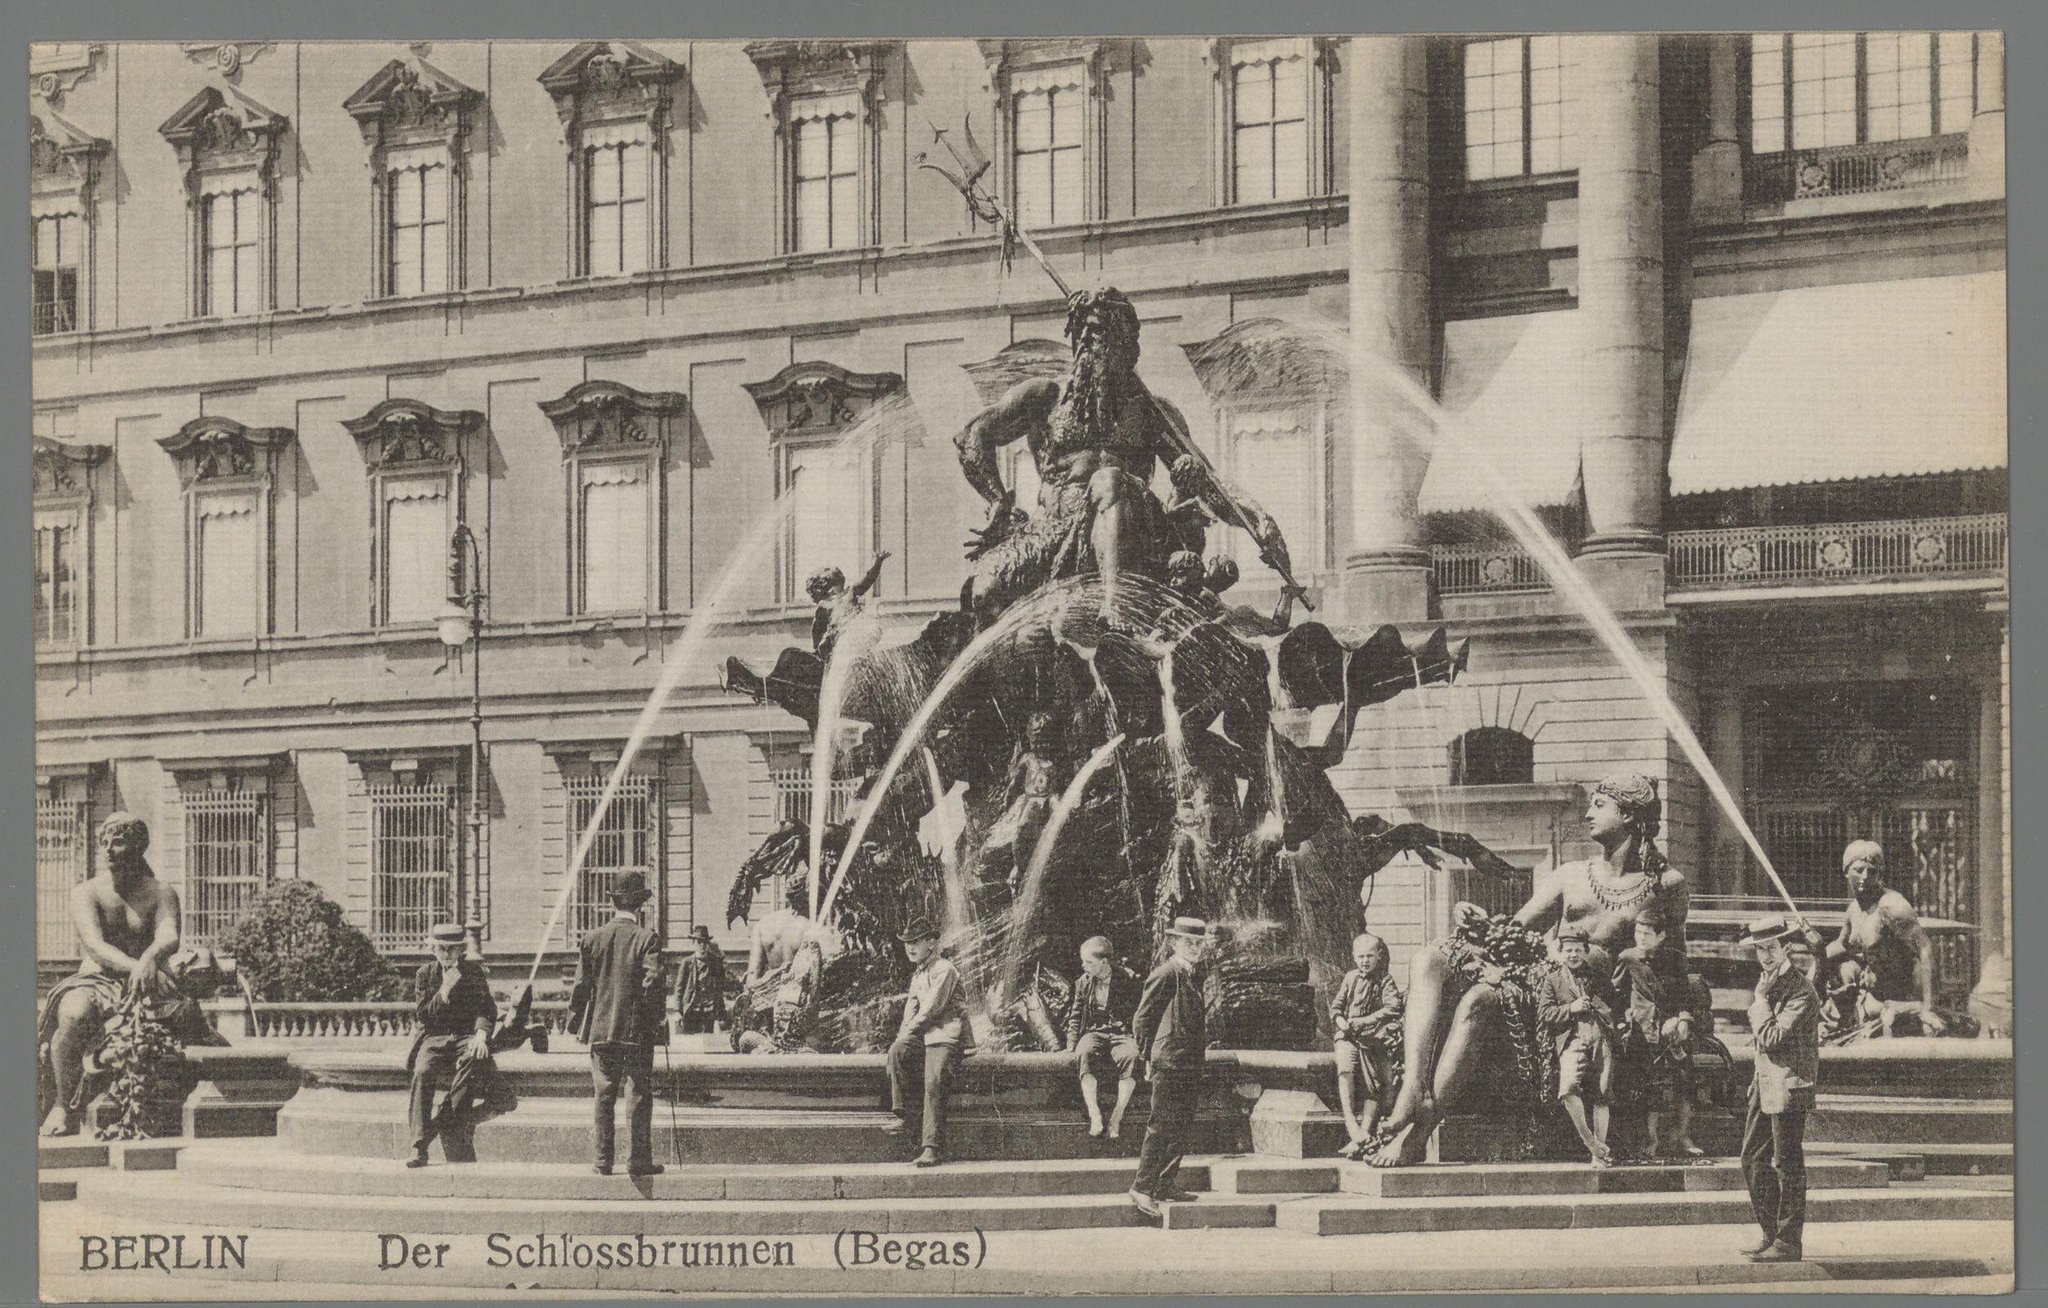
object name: ansichtkaart, prentbriefkaart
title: Berlin. Der Schlossbrunnen (Begas)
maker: Anonymous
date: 1905-1930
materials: cardboard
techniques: photograph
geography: berlin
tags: ornamental fountain